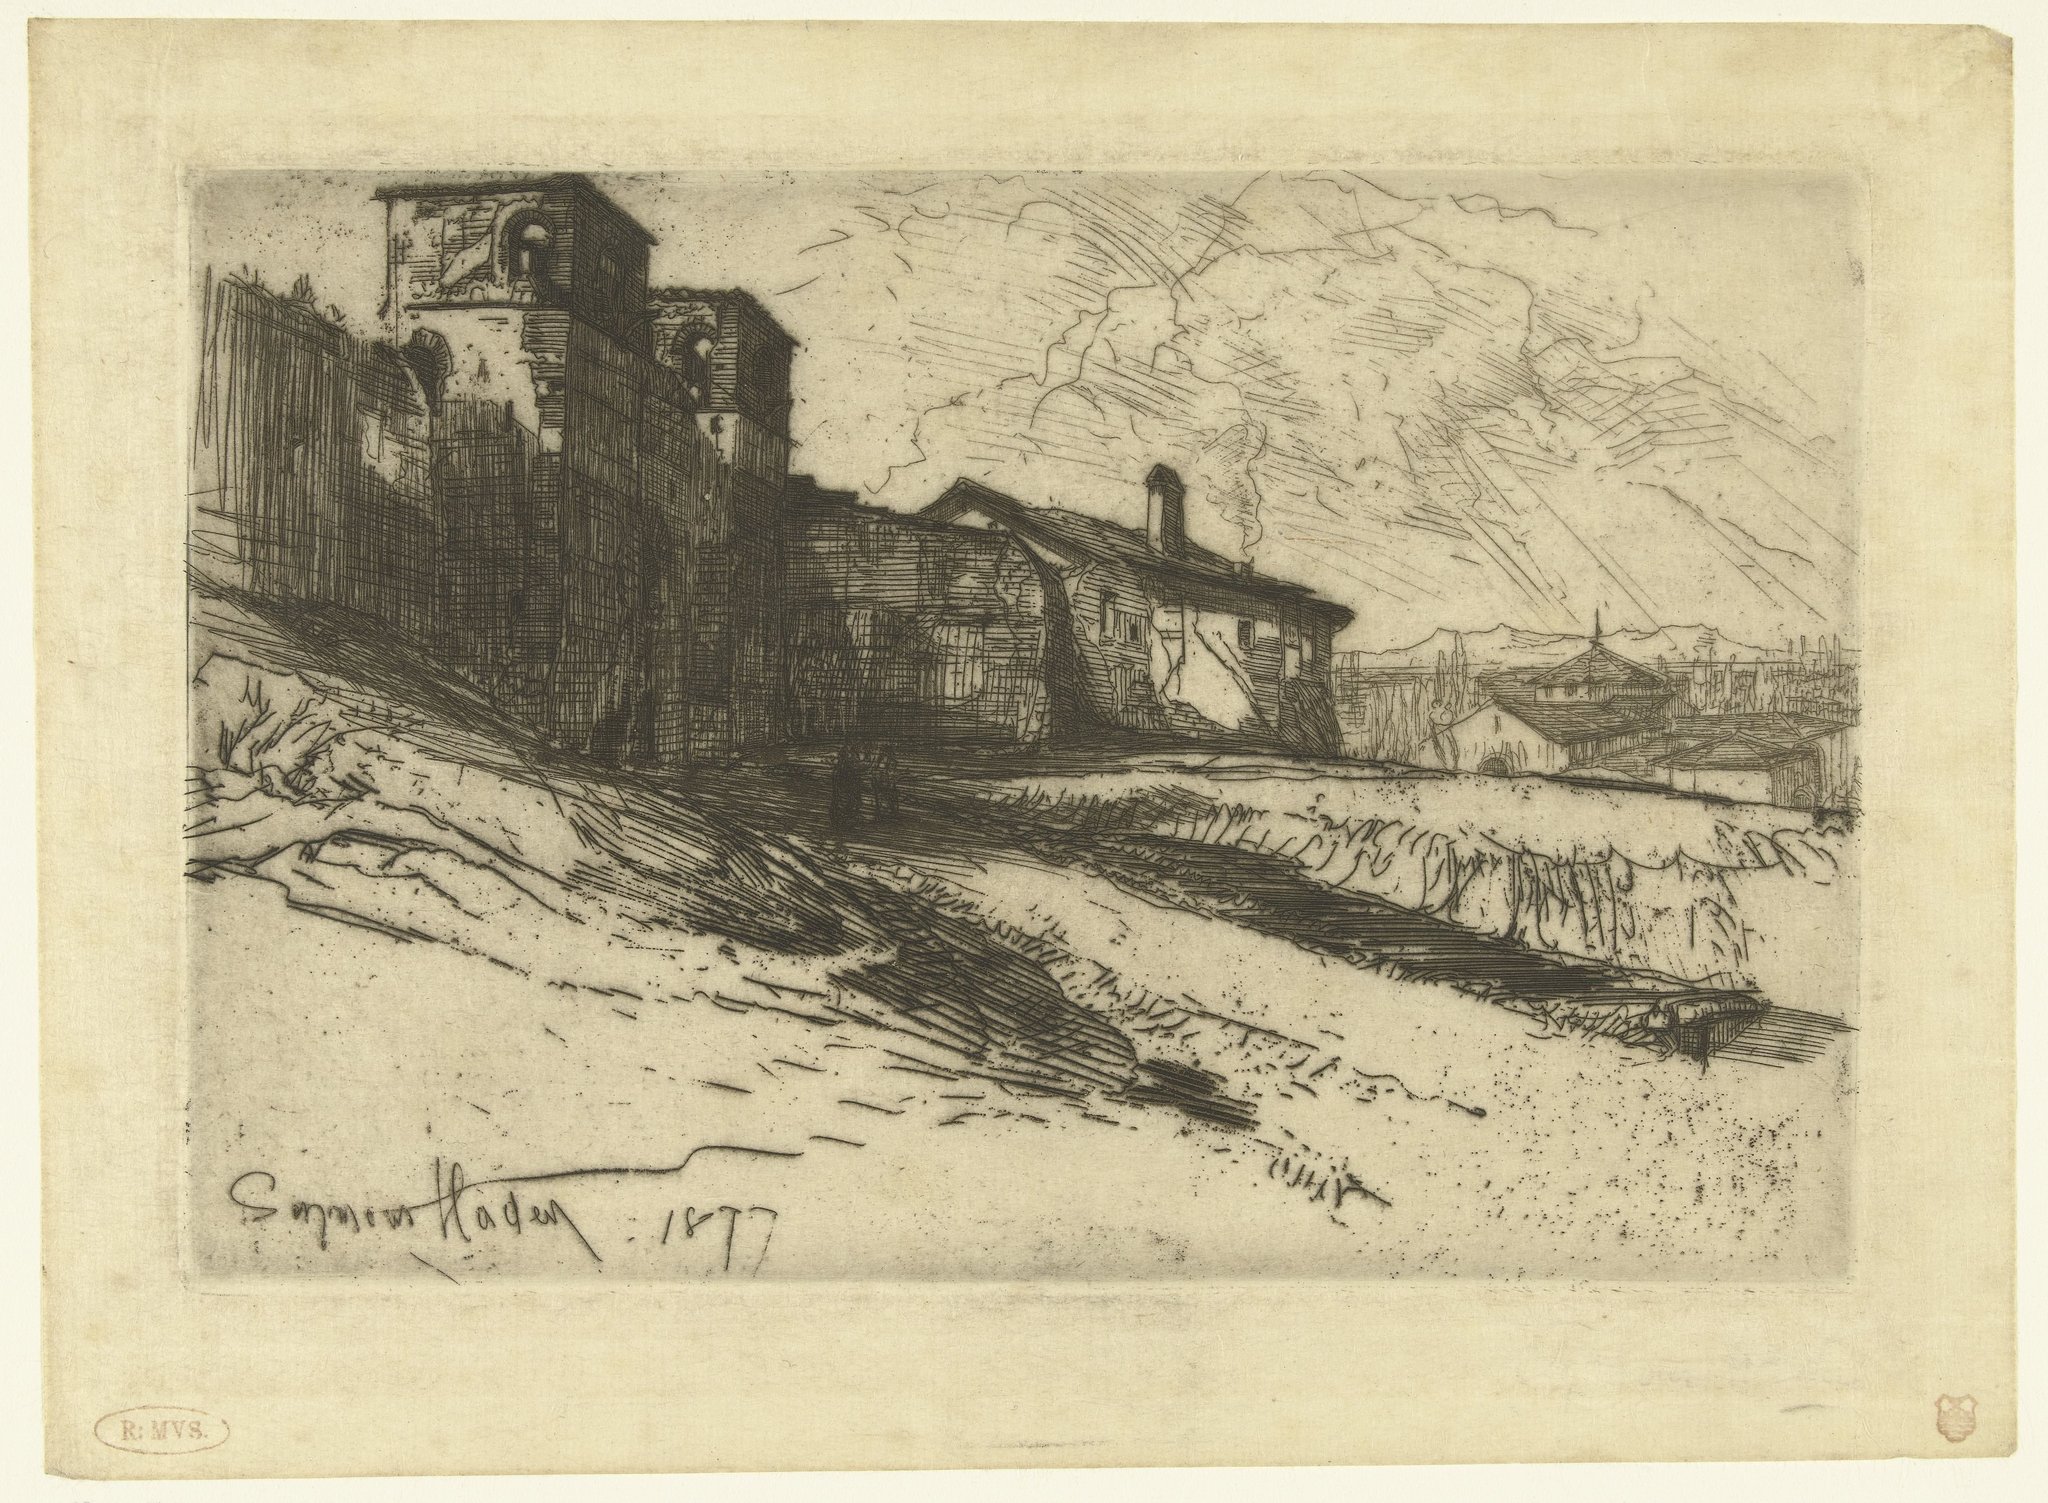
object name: print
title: Grim Spain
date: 1877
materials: paper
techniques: etching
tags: gate, entrance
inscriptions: collector's mark: Lugt 2760, collector's mark: Lugt 2228, collector's mark: Lugt 2786a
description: Gedrukt door Goulding voor The Fine Arts Society, om te publiceren in Frederick Wedmore's Four Masters of Etching, Londen 1883.